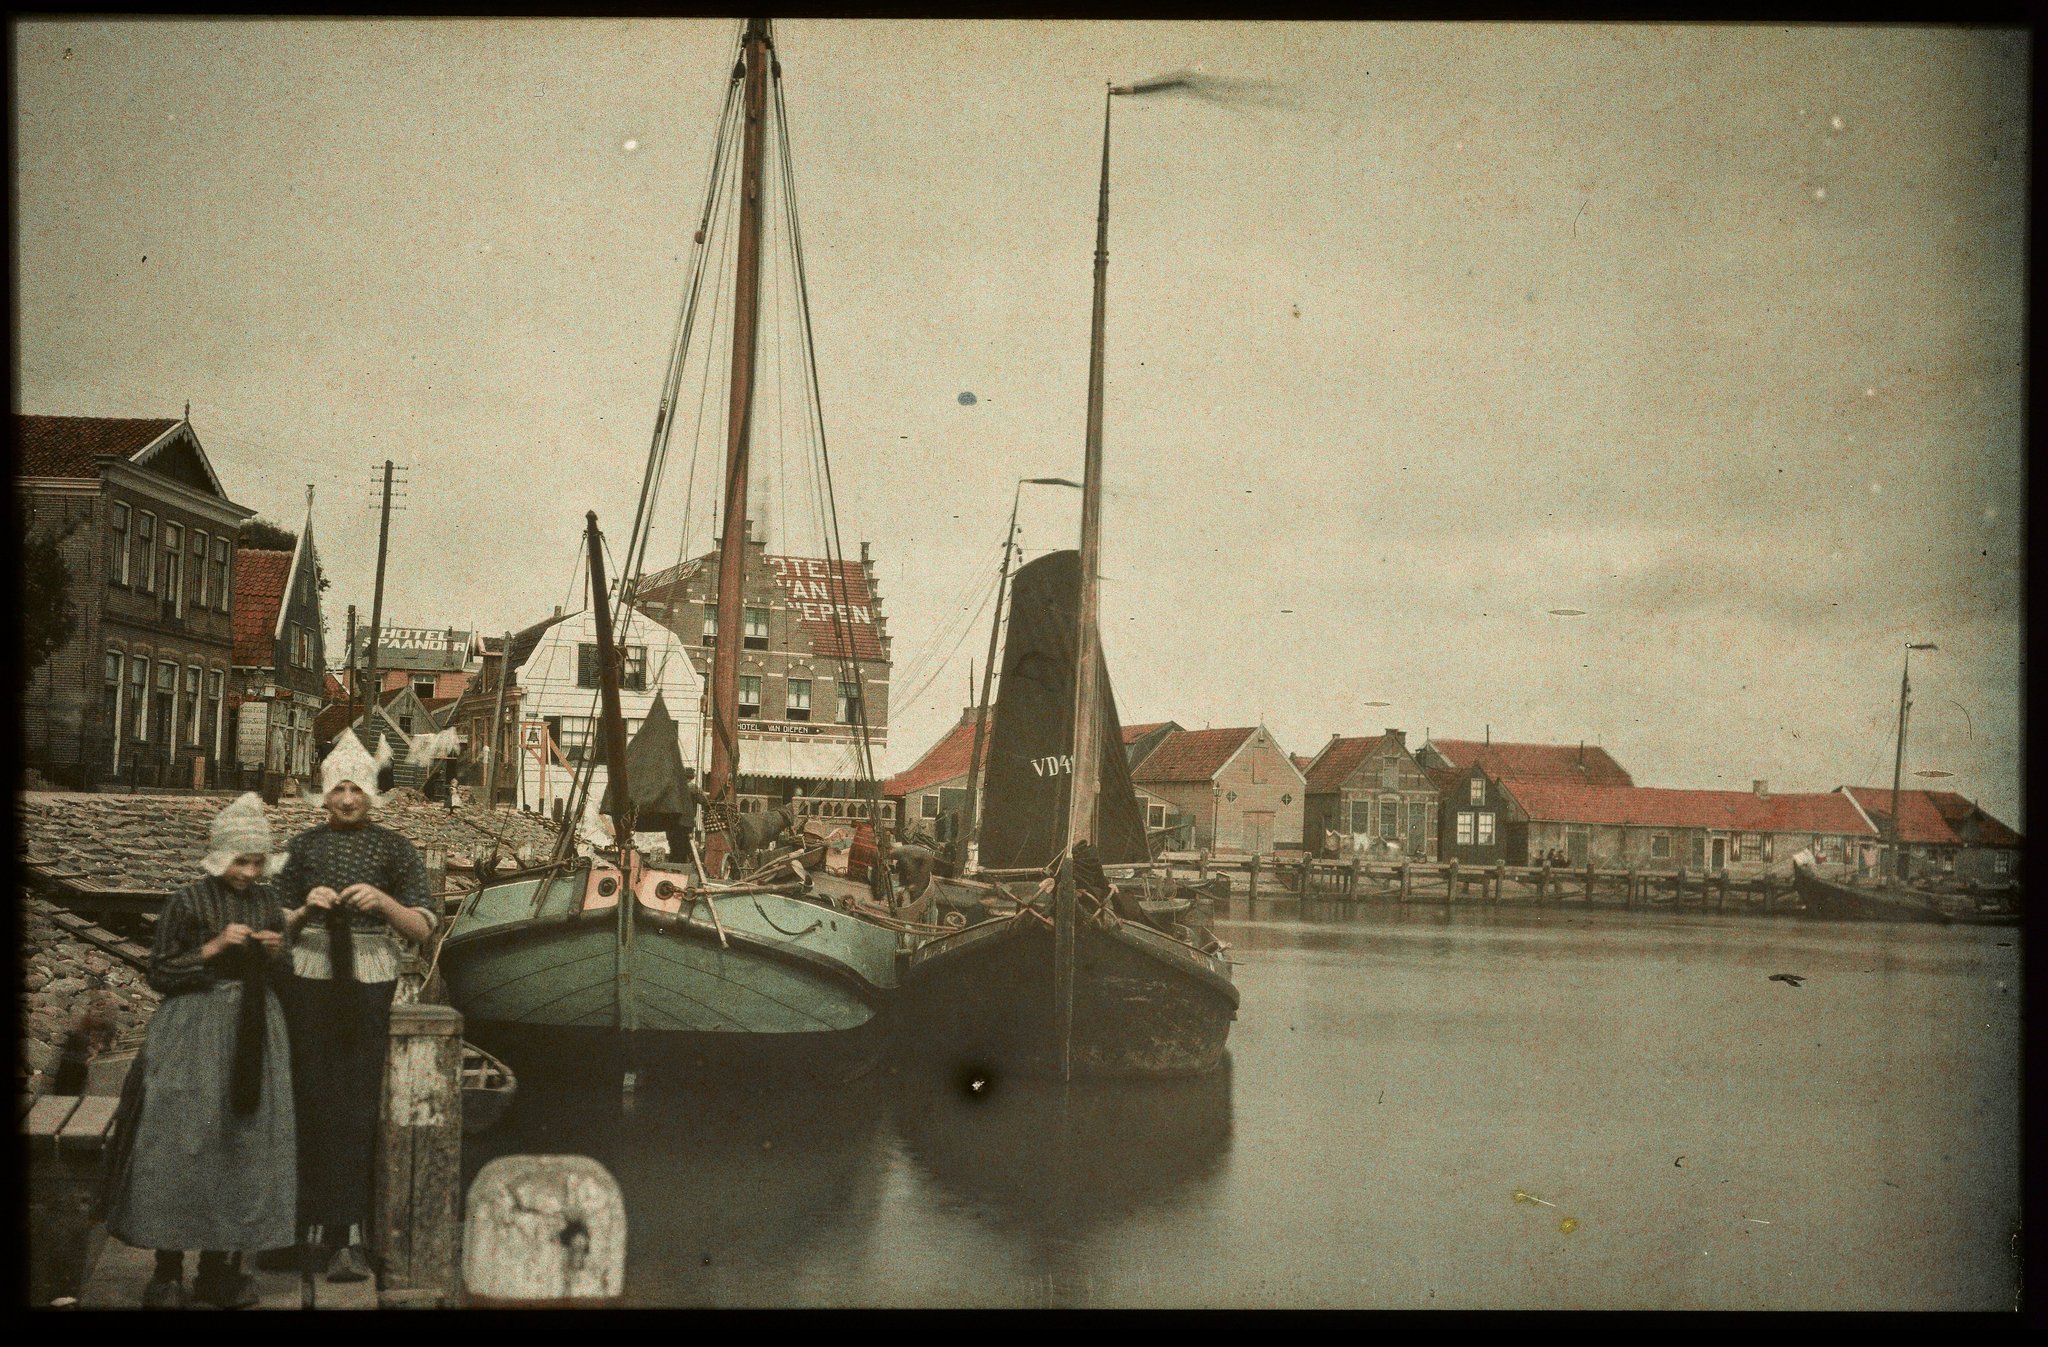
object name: glasdia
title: De haven van Volendam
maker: Anonymous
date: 1912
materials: glass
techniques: autochrome process, slide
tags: harbour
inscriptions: label